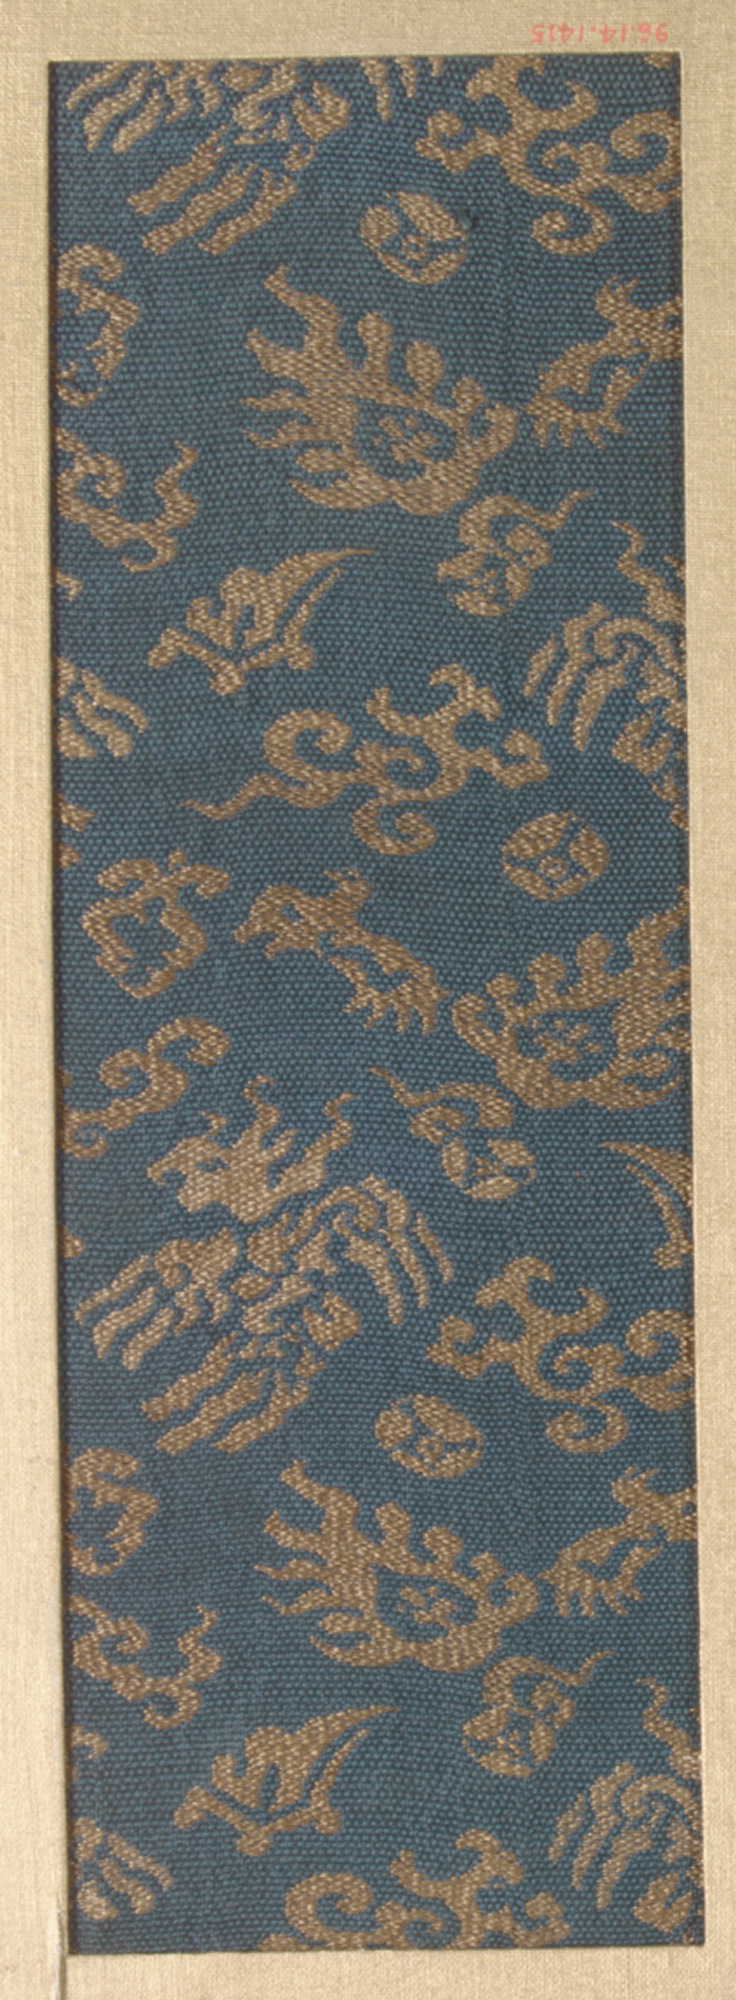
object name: piece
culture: japanese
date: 1701-1900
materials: silk